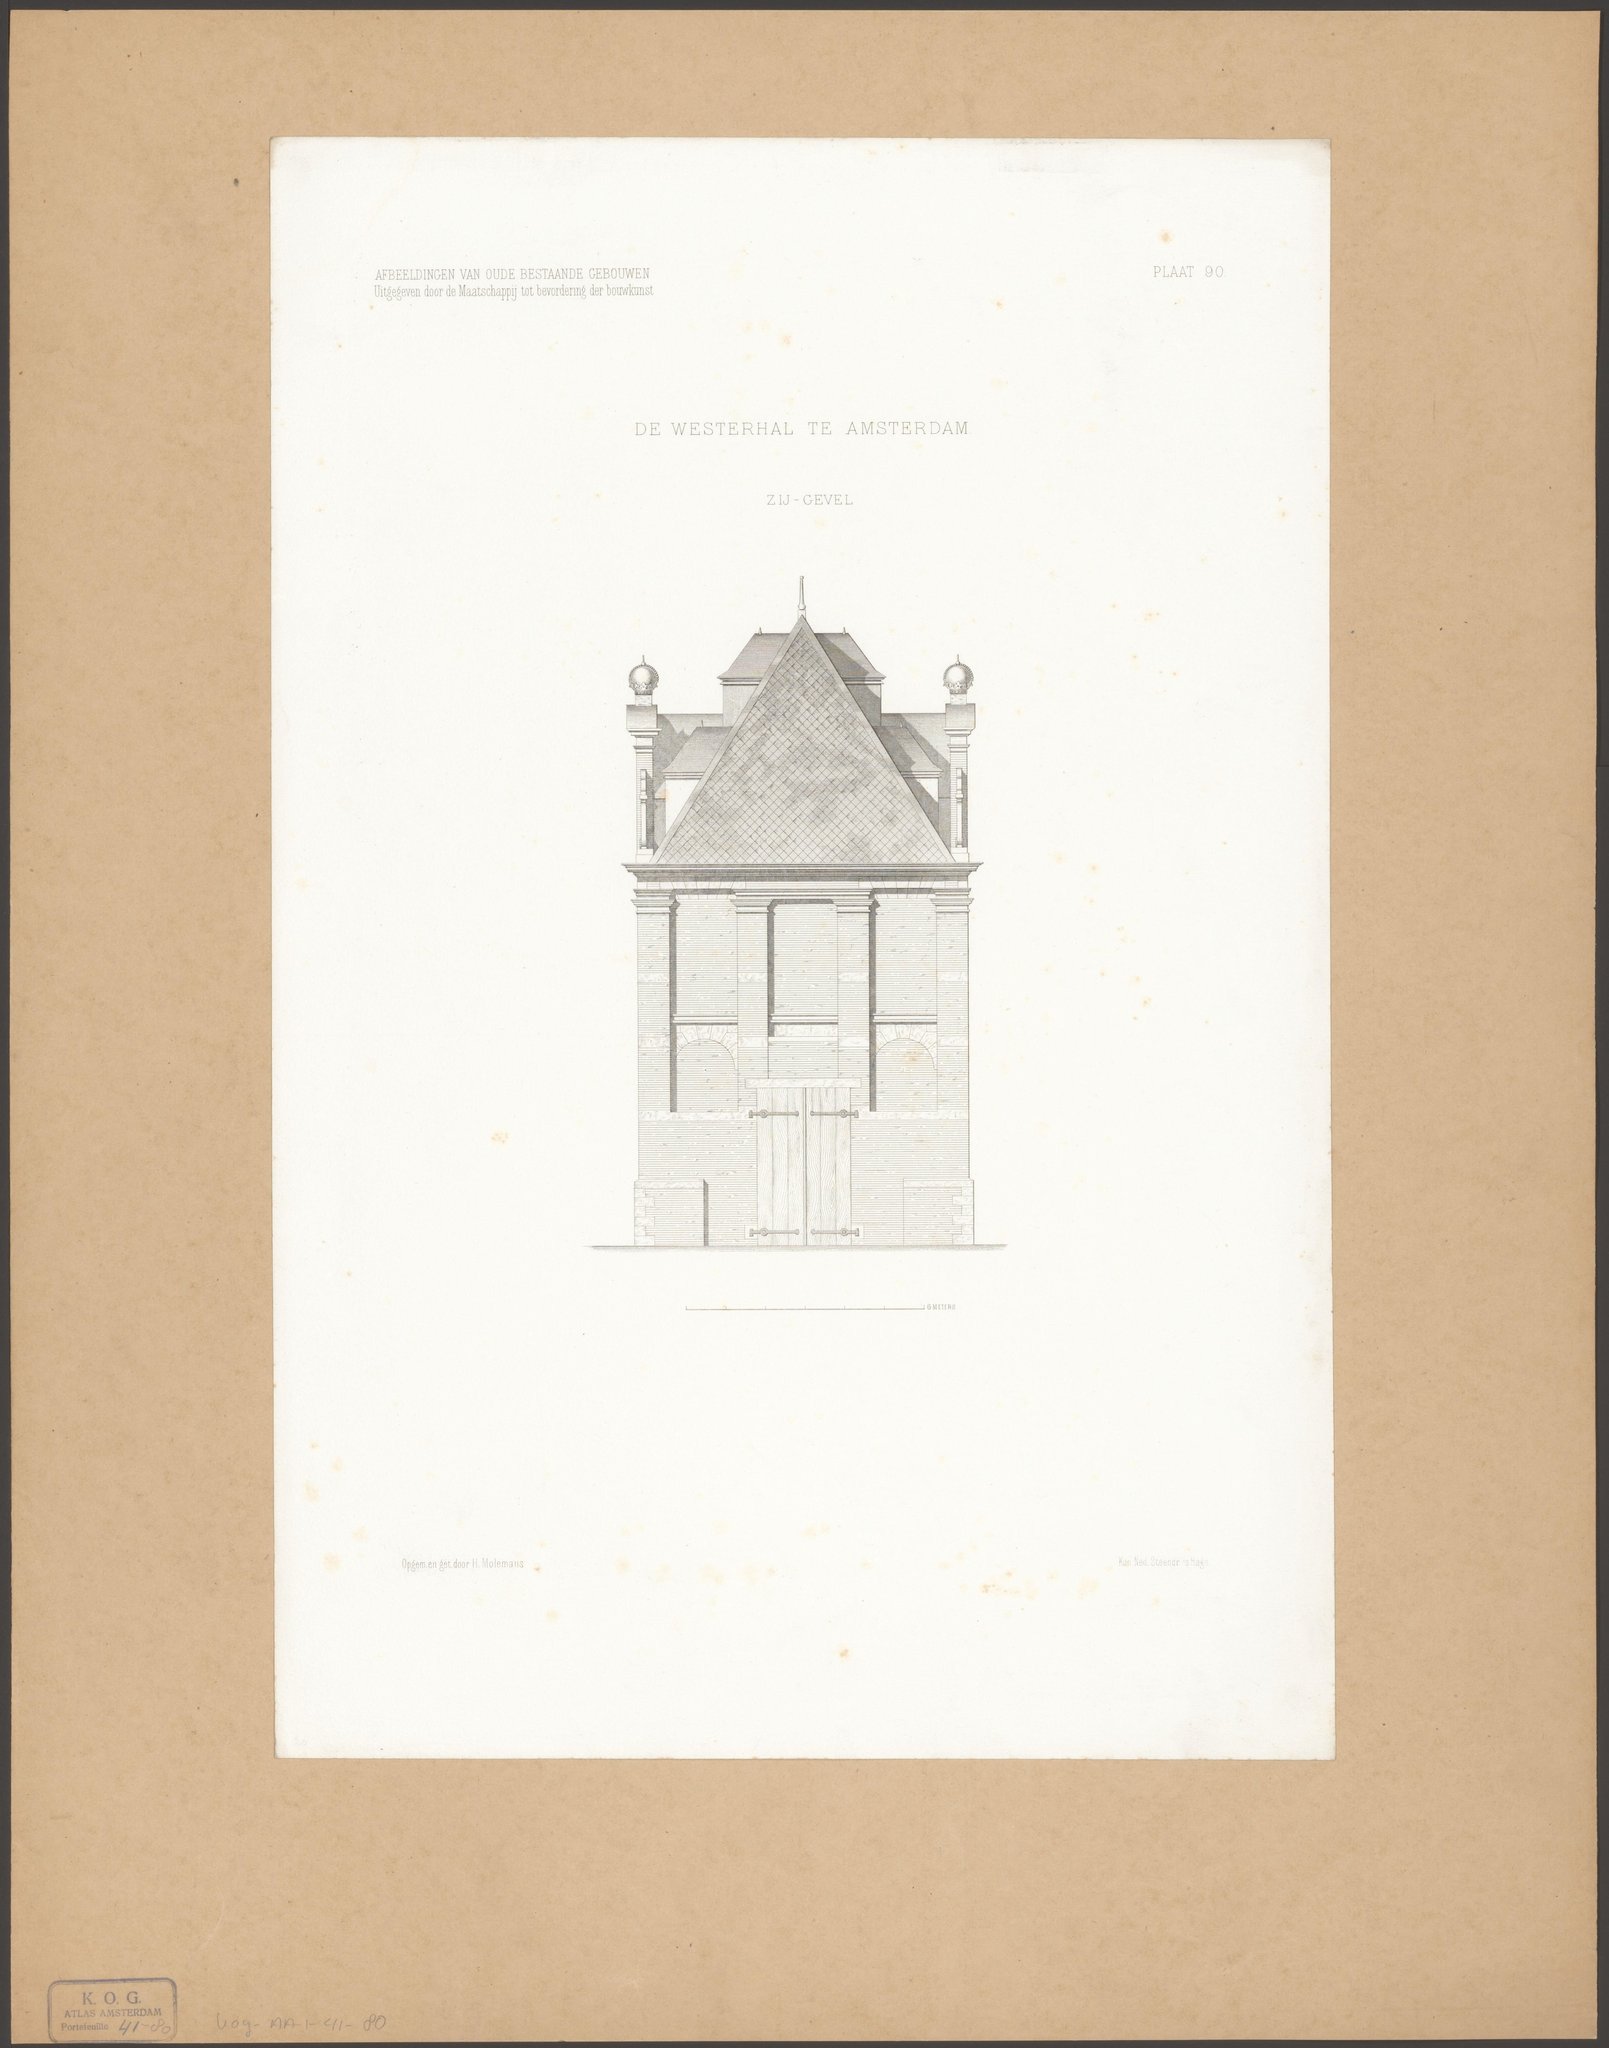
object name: print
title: De Westerhal te Amsterdam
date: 1857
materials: paper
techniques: lithograph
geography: the hague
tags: façade ~ architectural design or model, façade (of house or building), weigh-house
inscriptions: collector's mark: ‘41-80’ Lugt 1641b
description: Prent uit de serie: Afbeeldingen van oude bestaande gebouwen / uitgeg. door de Maatschappij tot Bevordering der Bouwkunst, Amsterdam; Van Bakkenes, Afl. 1 (1854) - 47 (1907).